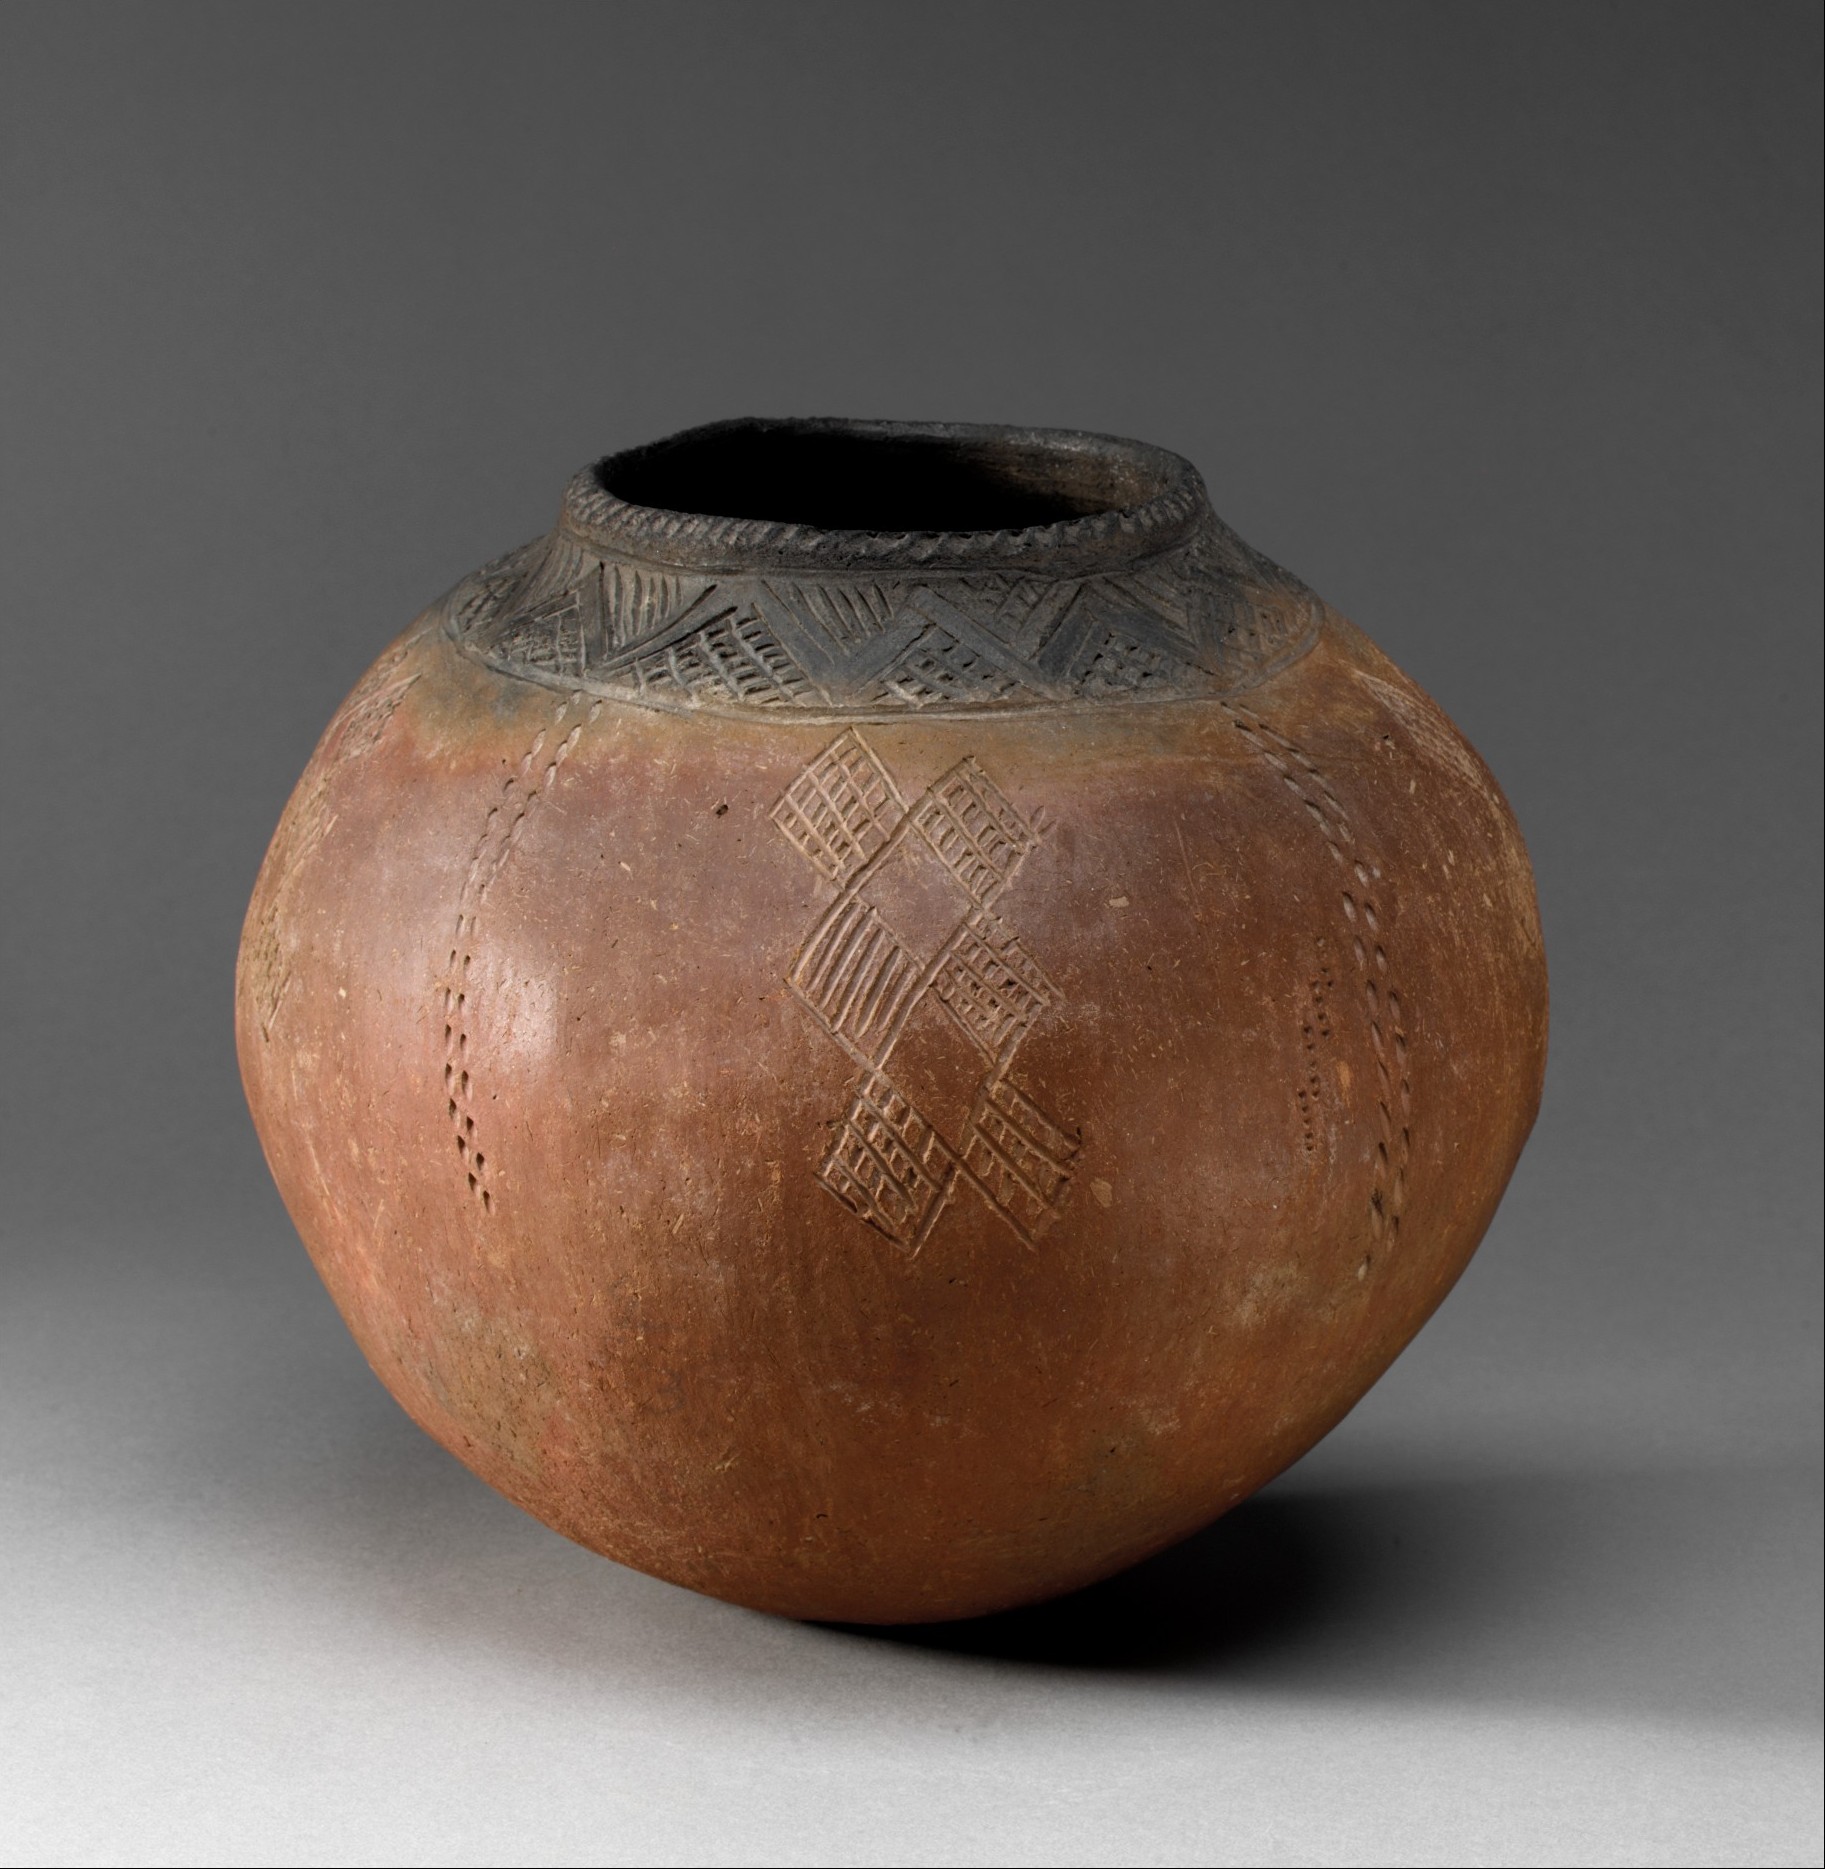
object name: jar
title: Storage Jar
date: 2000-1600 BCE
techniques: incising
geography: nubia